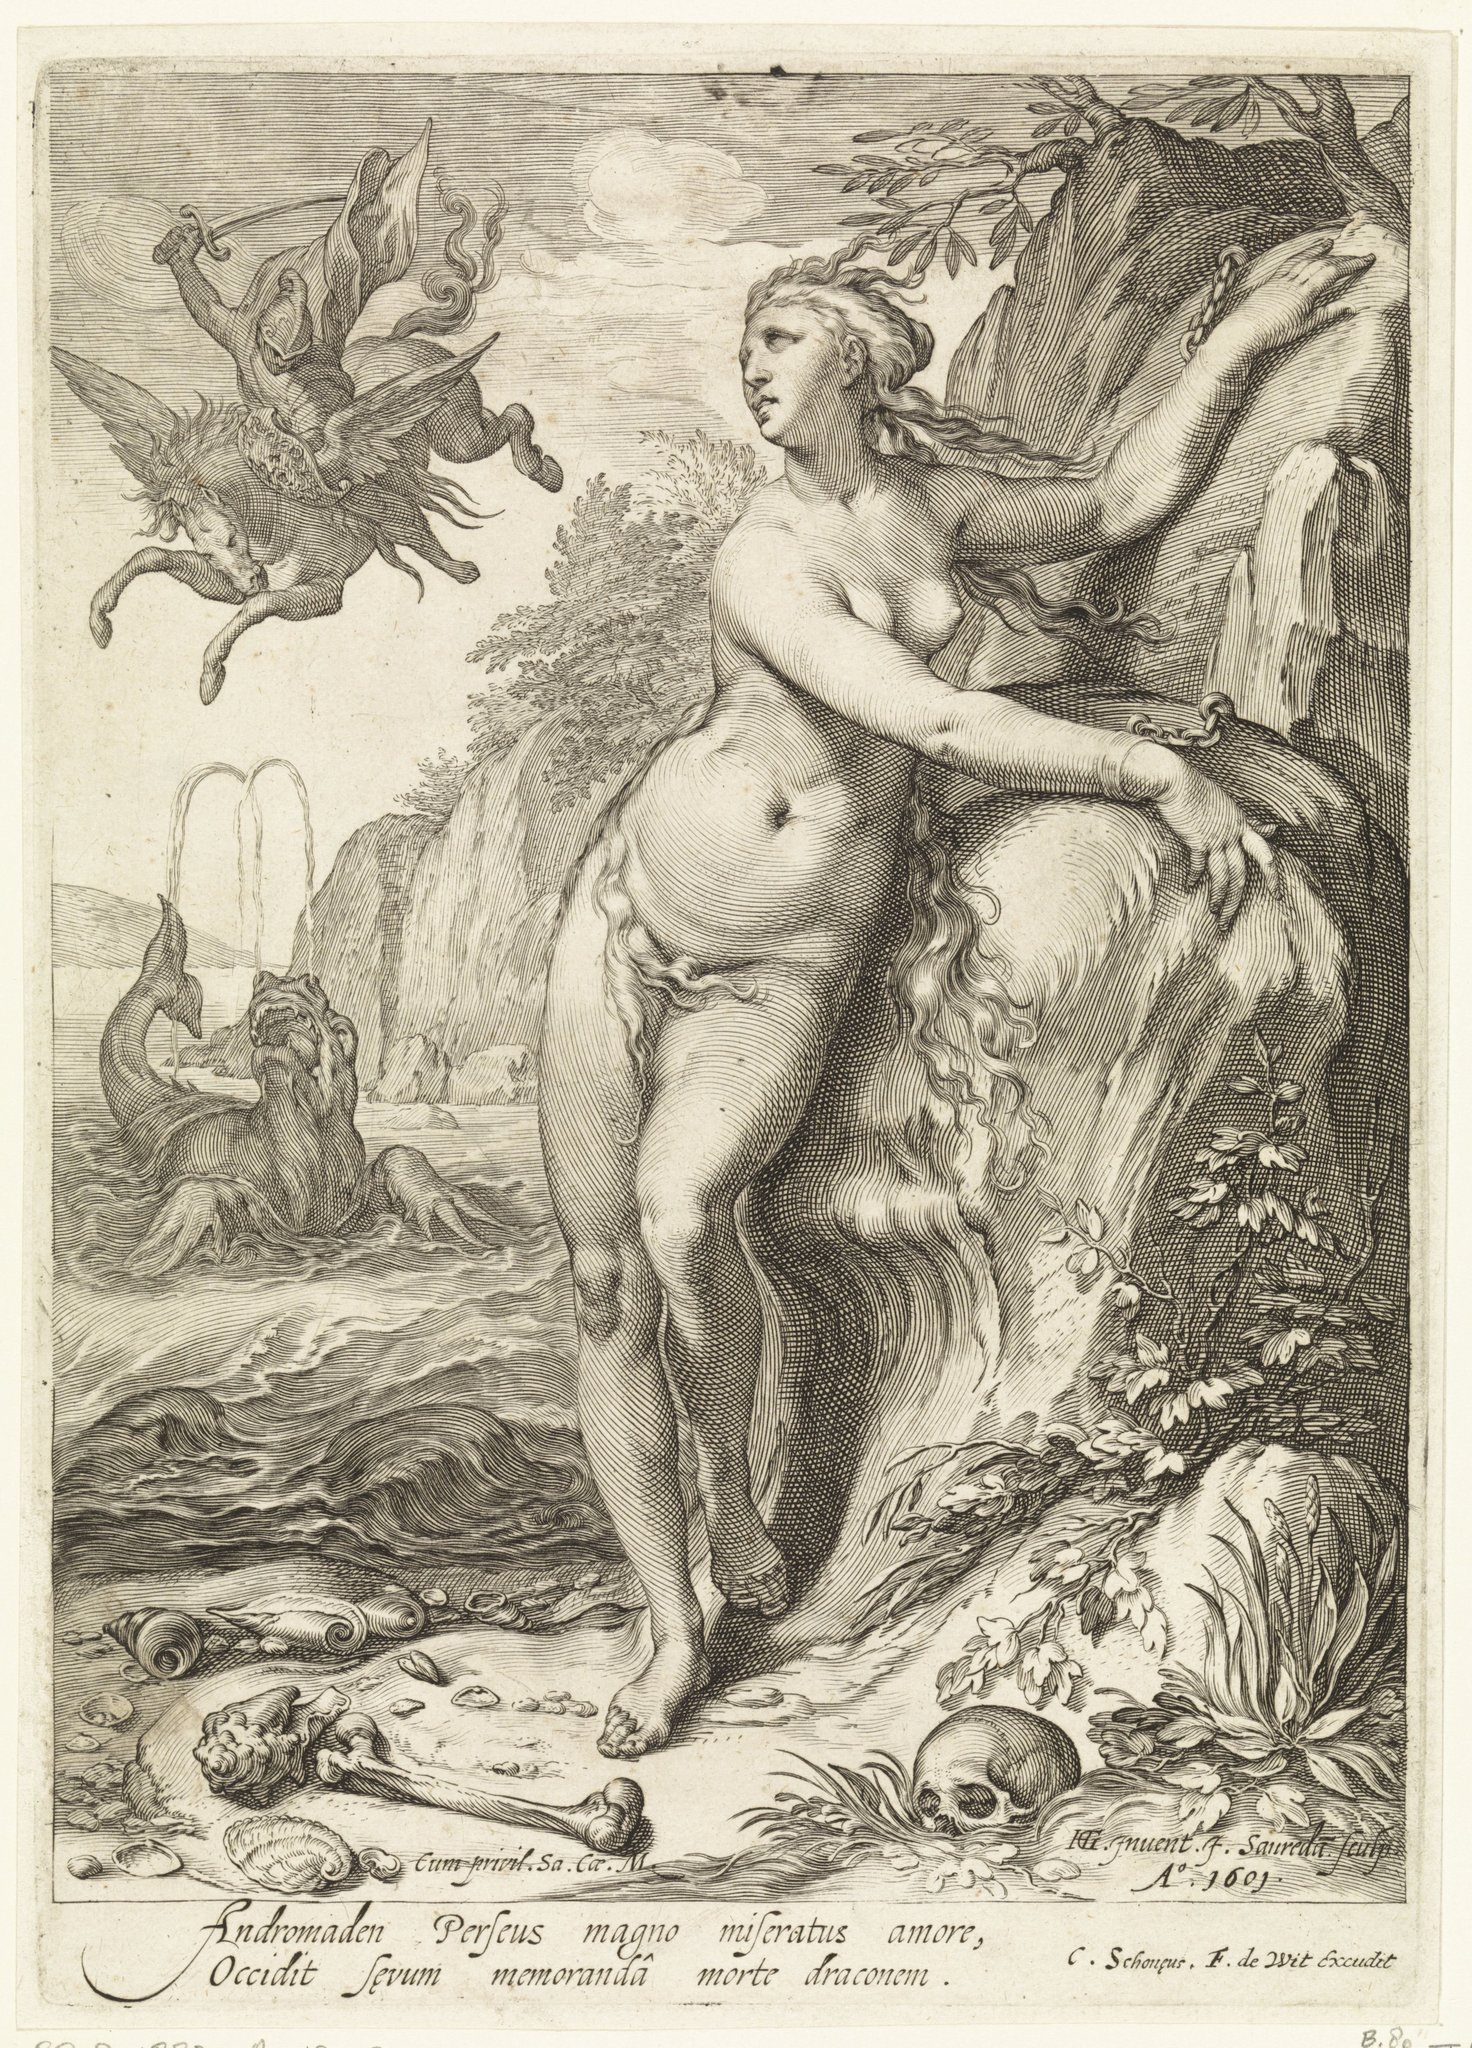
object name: print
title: Perseus en Andromeda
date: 1601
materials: paper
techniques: engraving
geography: amsterdam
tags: perseus kills the sea monster (or turns it into stone by showing it the gorgon's head) to release andromeda; sometimes her parents cepheus and cassiopea watch the scene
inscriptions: collector's mark: Lugt 2228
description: Andromeda, de dochter van een Ethiopische koning, is vastgeketend aan een rots. Op de achtergrond verslaat Perseus het zeemonster om Andromeda te kunnen komen redden.